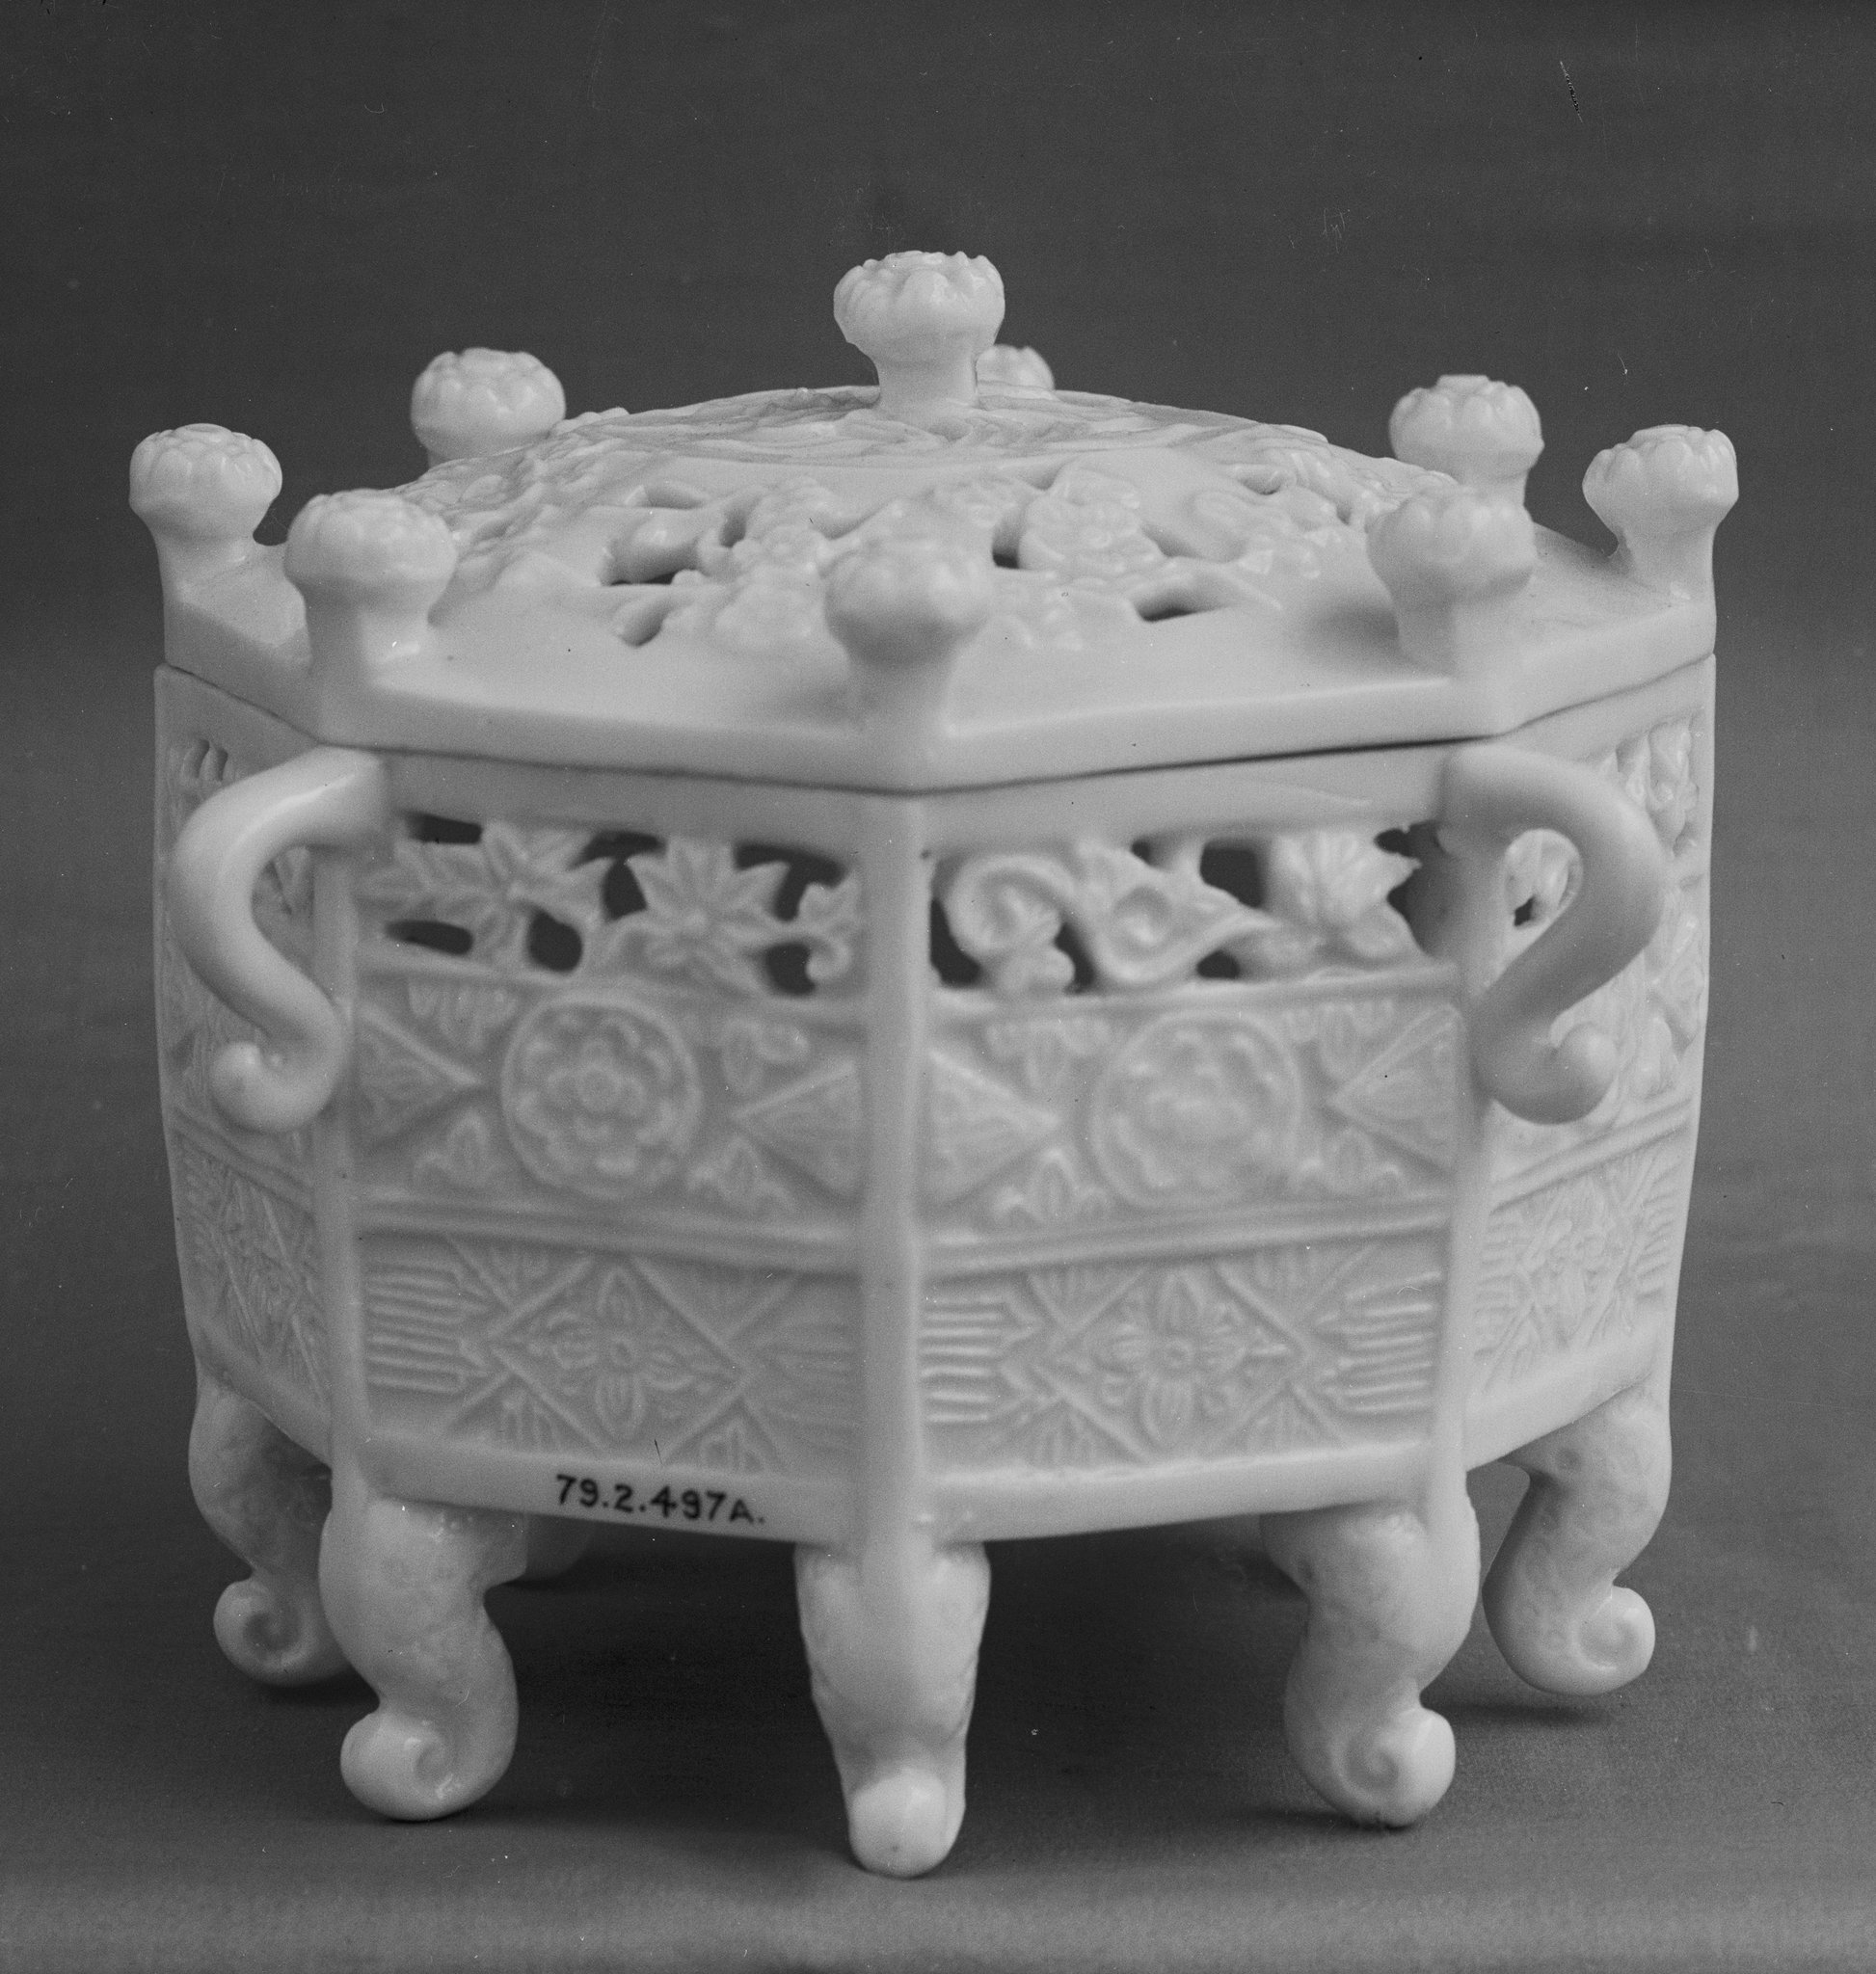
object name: covered incense burner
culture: chinese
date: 1701-1733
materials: glaze, porcelain